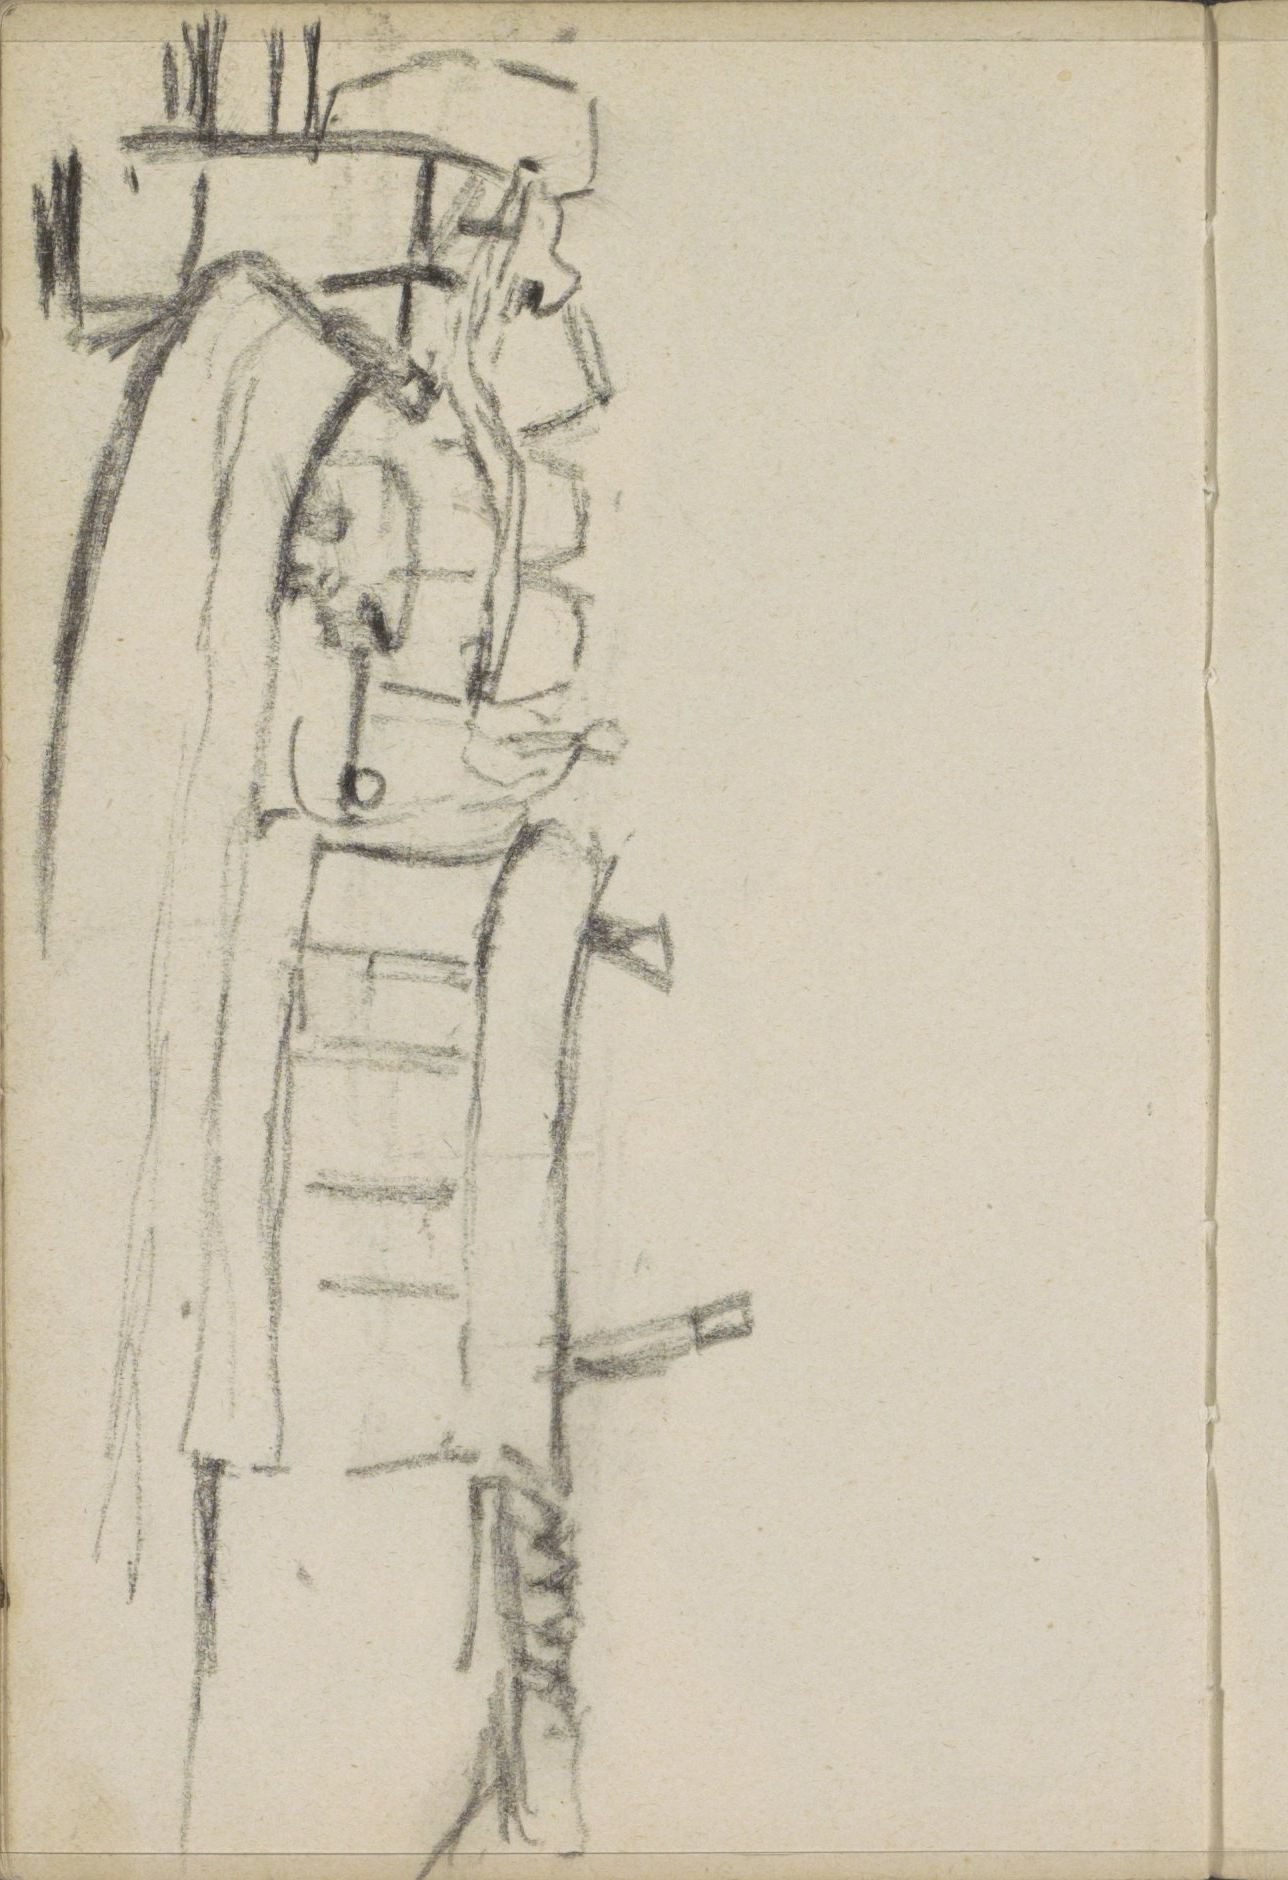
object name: sketchbook leaf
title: Figuur op een aangemeerde boot, mogelijk in de Prinseneilandsgracht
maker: george hendrik breitner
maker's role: draughtsman, painter, print maker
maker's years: 1857-1923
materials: chalk, paper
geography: amsterdam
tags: ships (in general), civic architecture; edifices; dwellings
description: Op de achtergrond gebouwen, mogelijk op Prinseneiland. Pagina 89 uit een schetsboek met 46 bladen.